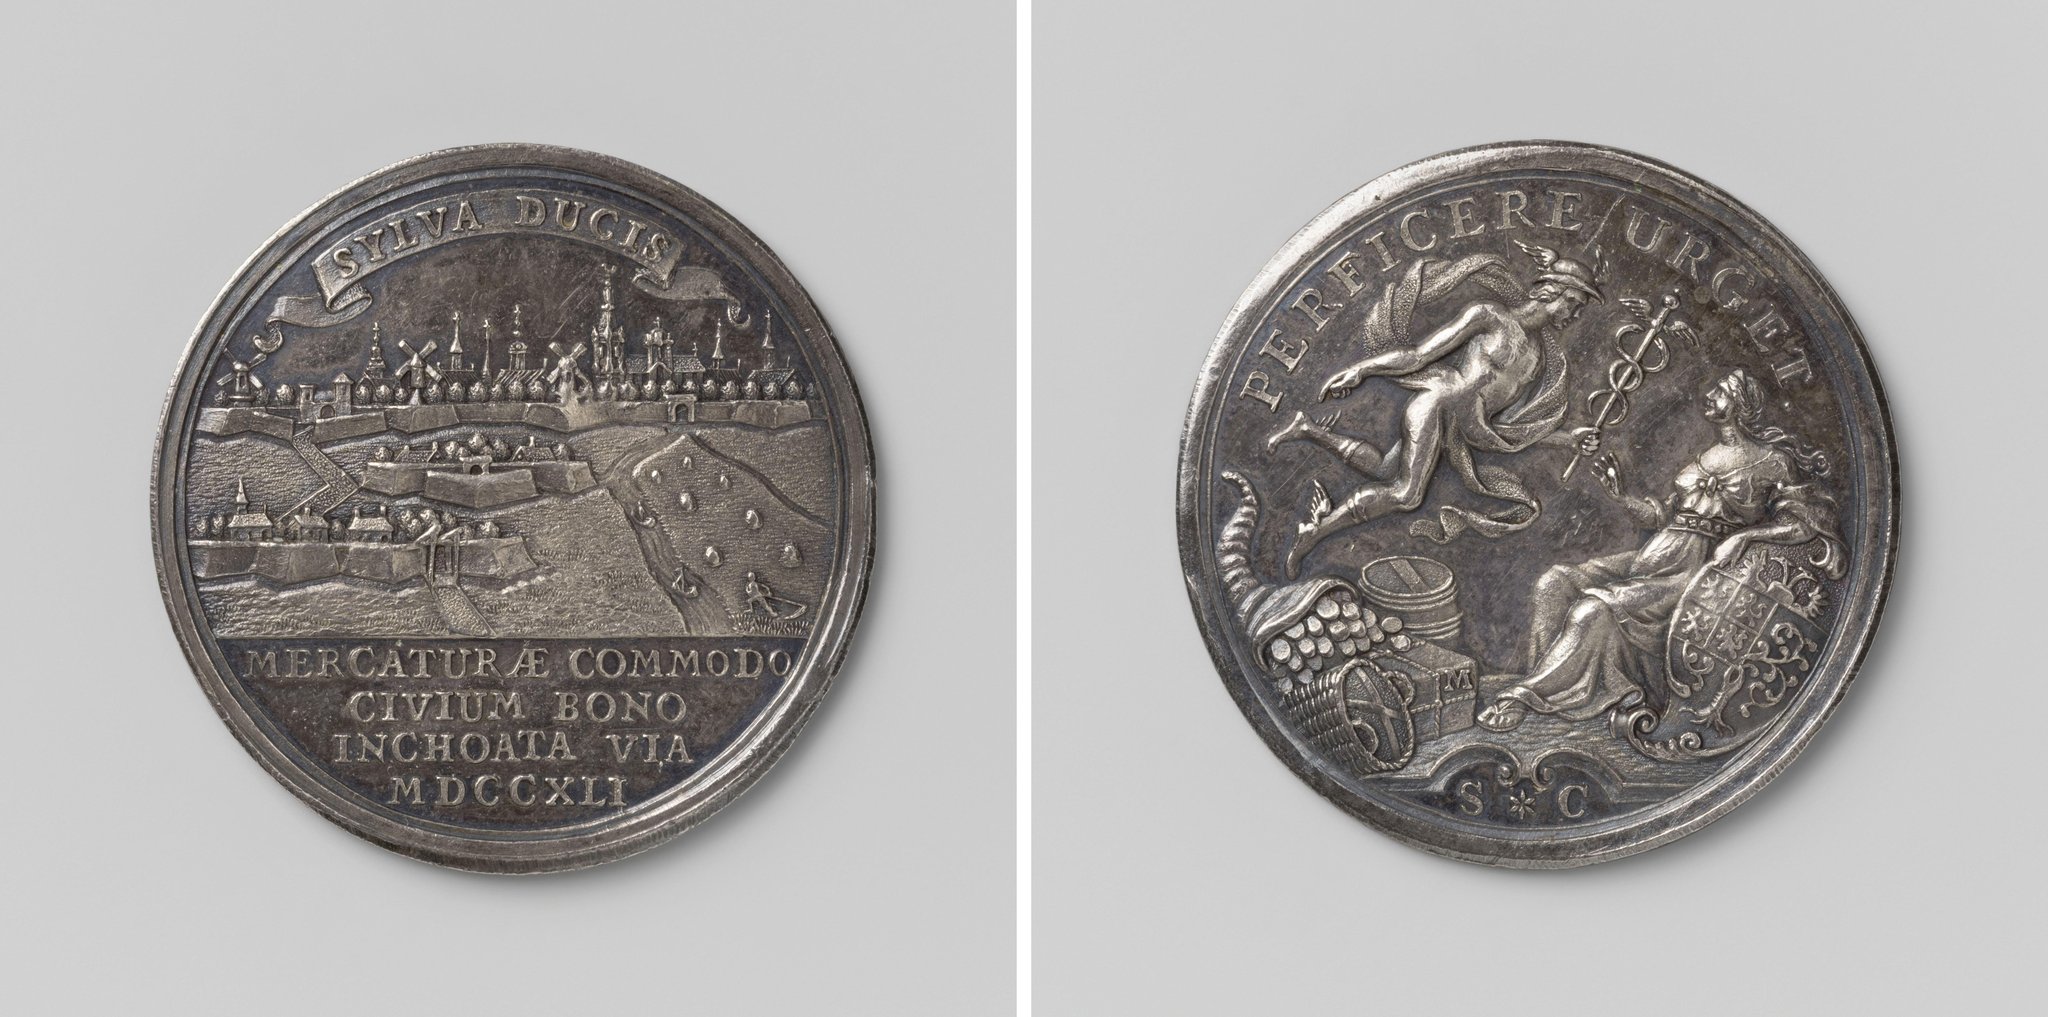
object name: council medal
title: 's-Hertogenbosch, vroedschapspenning op de aanleg van de steenweg van 's-Hertogenbosch naar Eindhoven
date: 1741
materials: silver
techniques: striking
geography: den bosch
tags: den bosch